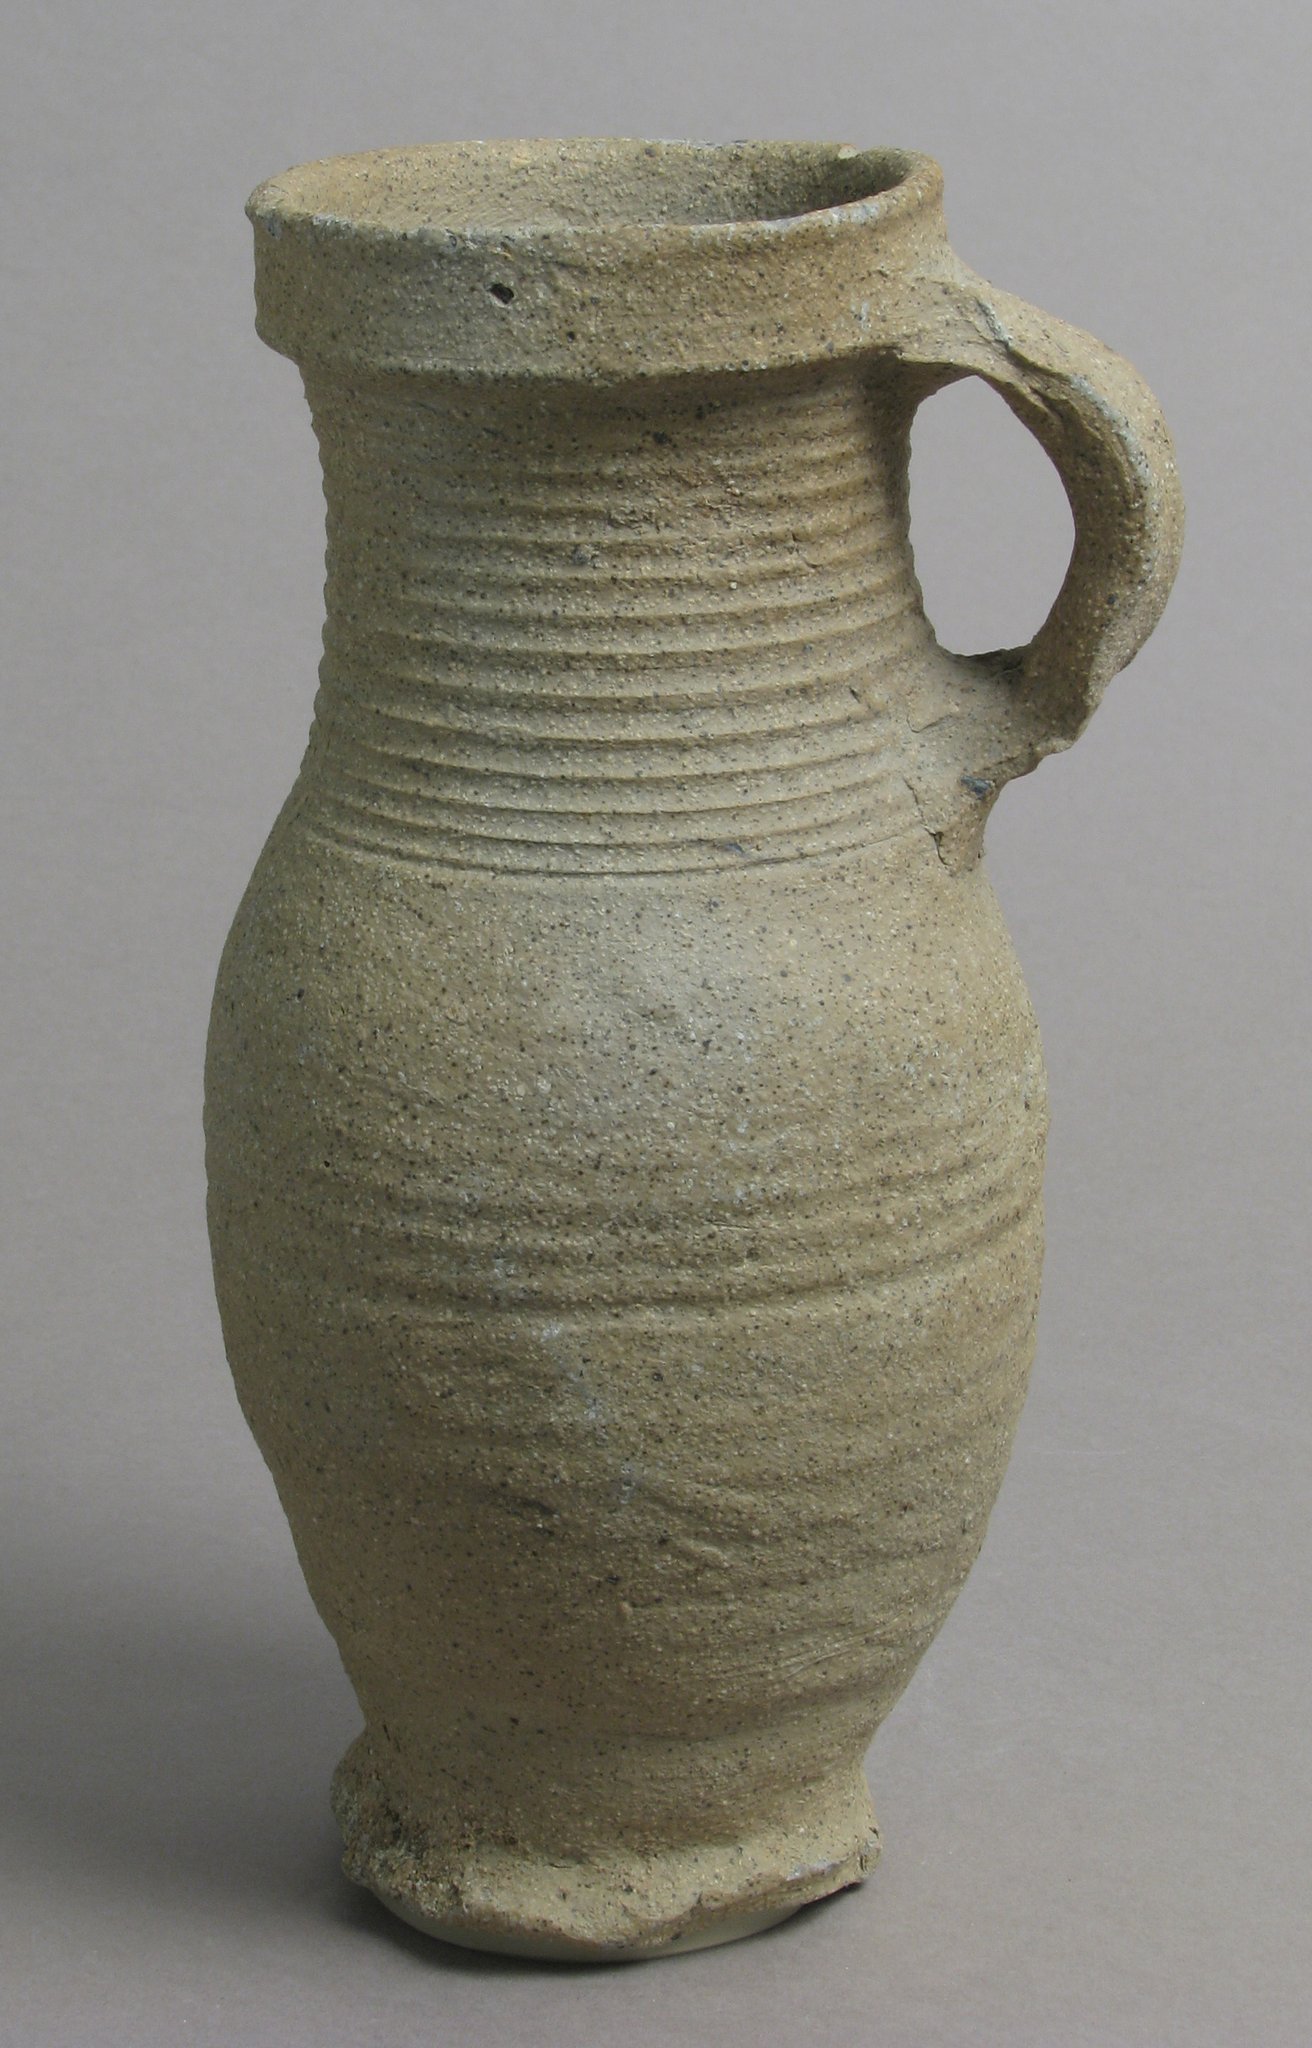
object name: jug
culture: german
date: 1301-1350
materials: stoneware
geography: germany